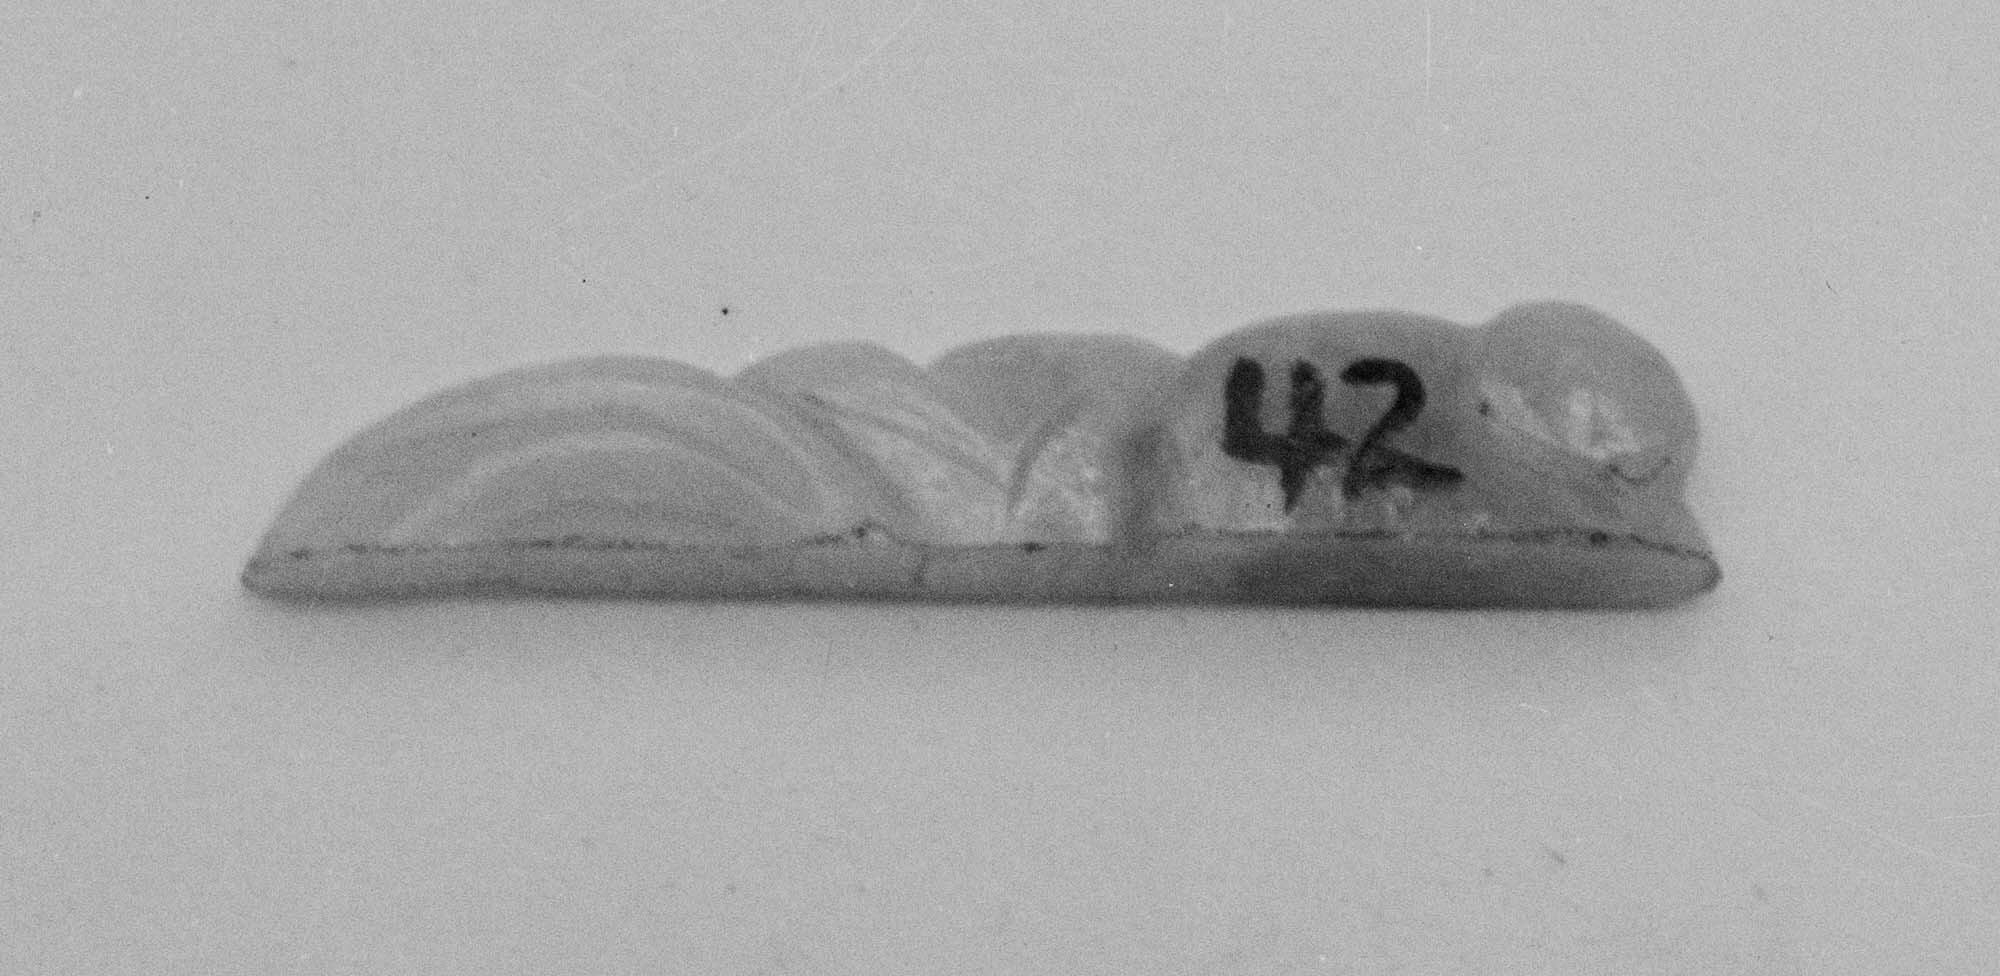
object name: pendant fragment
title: Fragment of a Pendant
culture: chinese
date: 1902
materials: jade